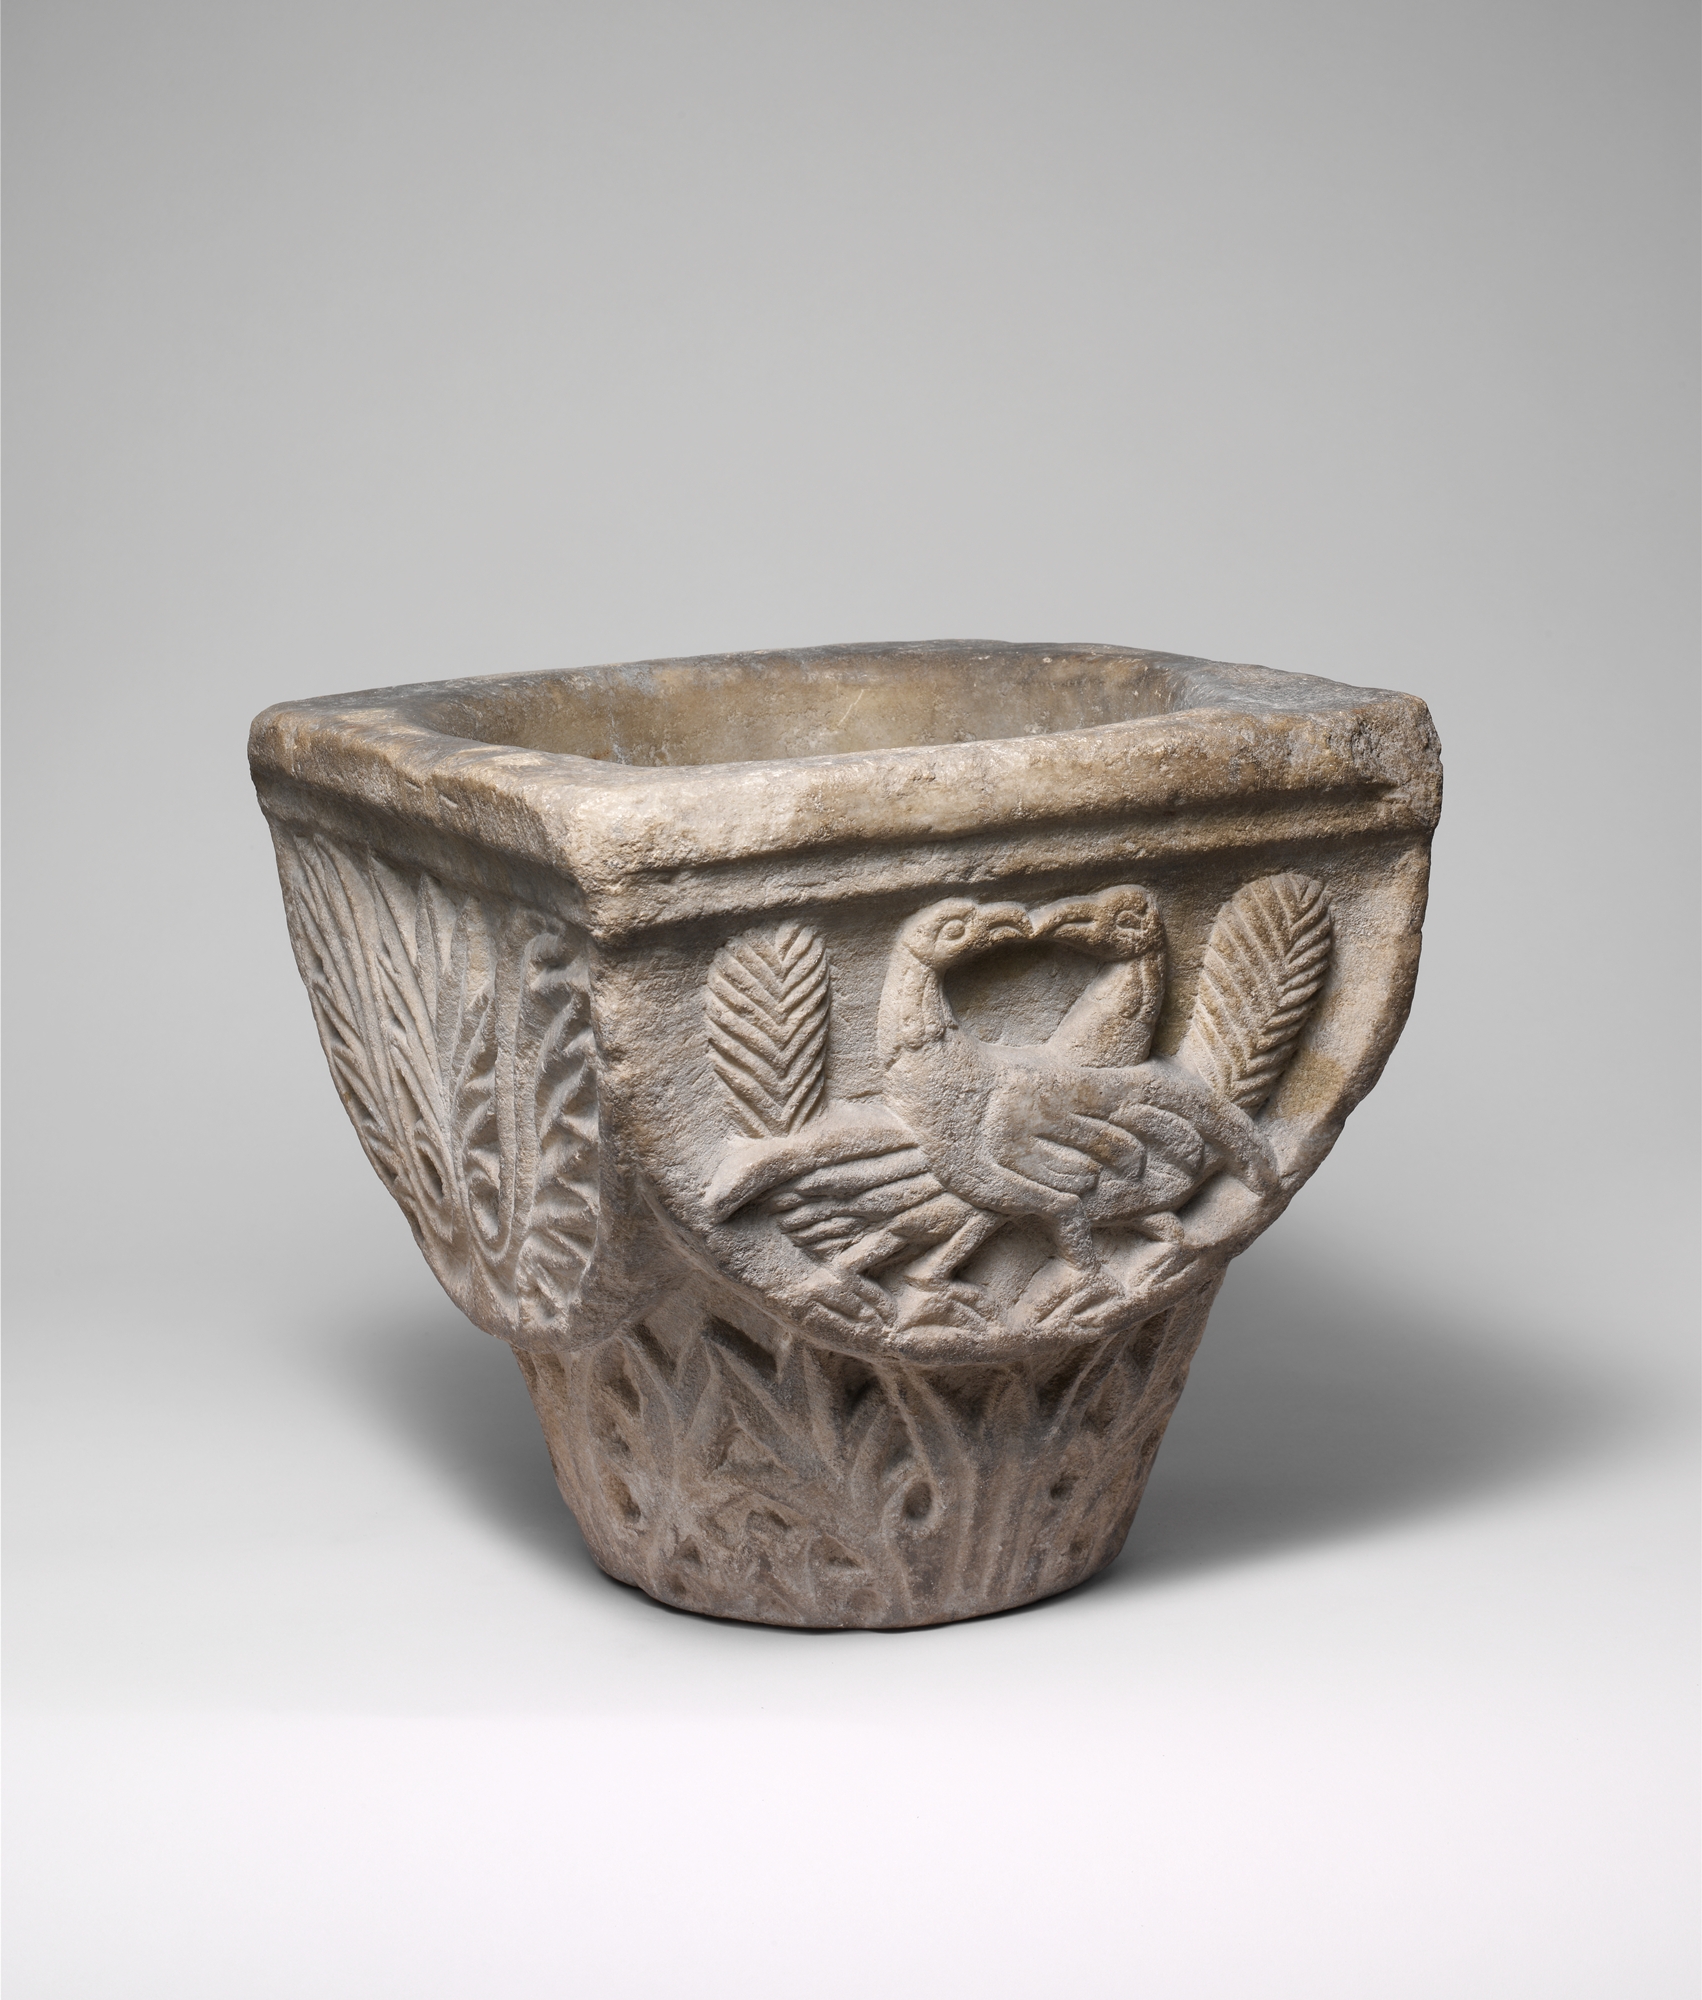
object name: capital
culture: northeast italian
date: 1101-1200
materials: marble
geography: italy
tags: birds